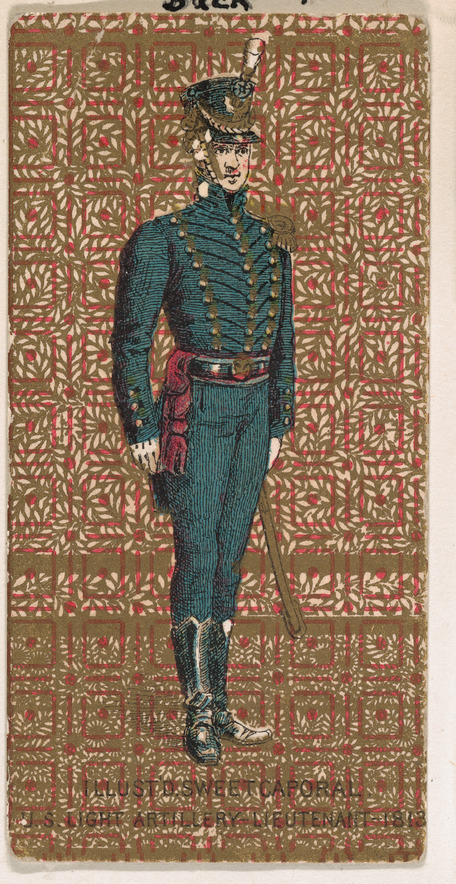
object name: print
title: Lieutenant, Light Artillery, United States Army, 1812, from the Military Series (N224) issued by Kinney Tobacco Company to promote Sweet Caporal Cigarettes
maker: kinney brothers tobacco company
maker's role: publisher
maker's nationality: american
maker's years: 1869-2011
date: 1888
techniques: color lithograph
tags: military,men